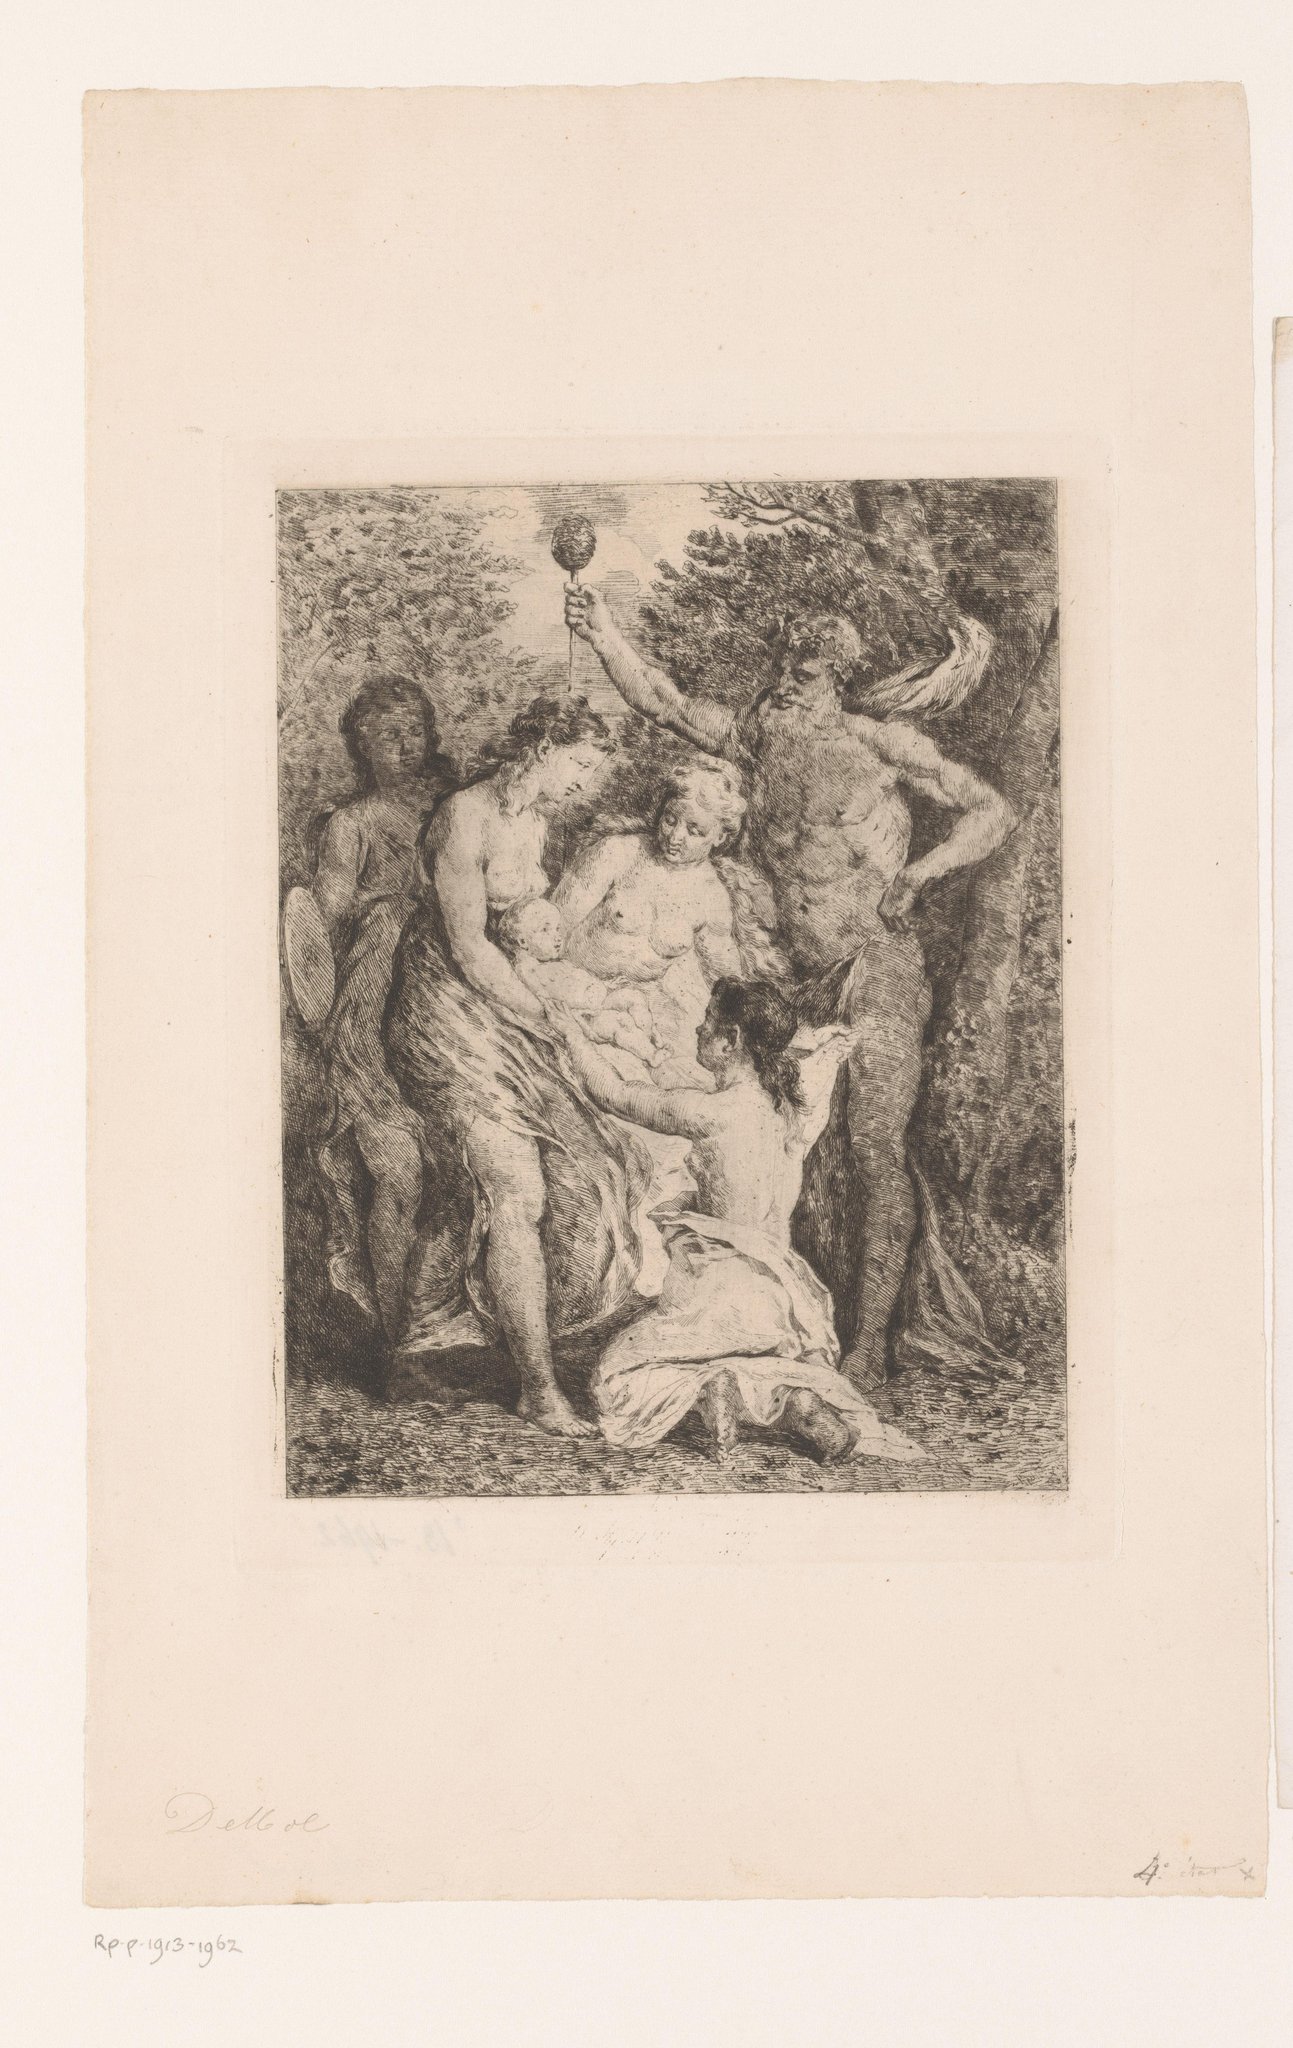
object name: print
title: Mercurius geeft baby Bacchus aan de nimfen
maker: adolphe léonard de mol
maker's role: print maker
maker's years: 1834-1877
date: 1844-1877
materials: paper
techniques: drypoint, etching, intaglio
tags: infancy, upbringing of bacchus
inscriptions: collector's mark: Lugt 2228